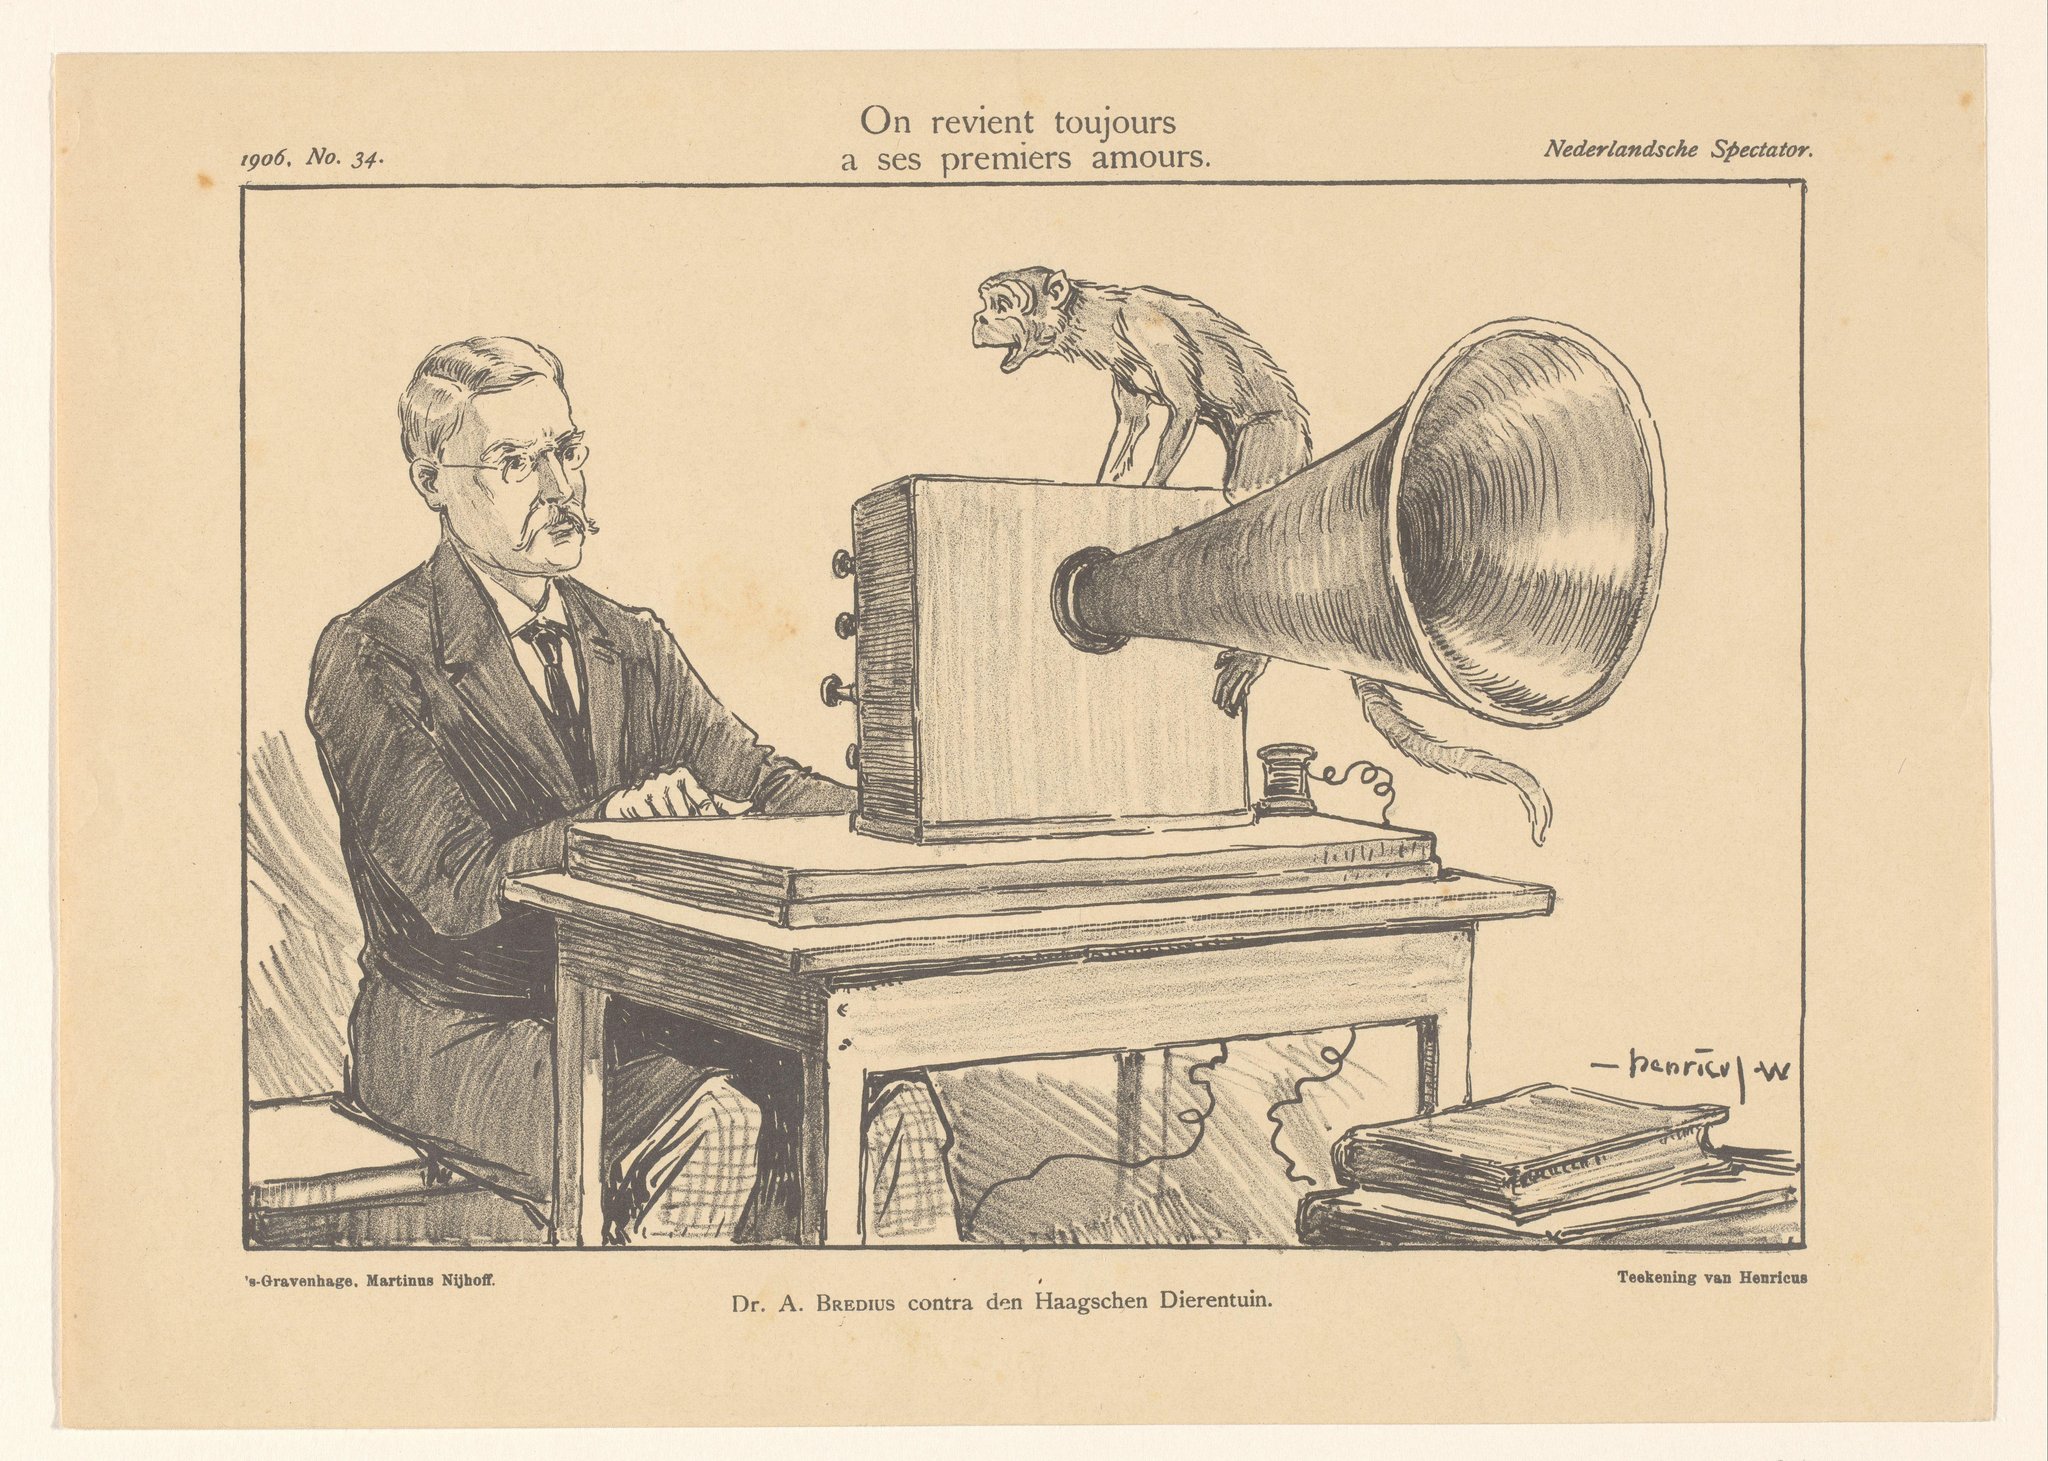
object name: cartoon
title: On revient toujours a ses premiers amours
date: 1906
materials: paper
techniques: lithograph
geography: the hague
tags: amsterdam, abraham bredius, historical persons, political caricatures and satires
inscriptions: collector's mark: Lugt 2228a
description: Abraham Bredius zit aan een tafel bij een apparaat met een hoorn waarop een aap zit. Een tweede aap springt van de tafel.